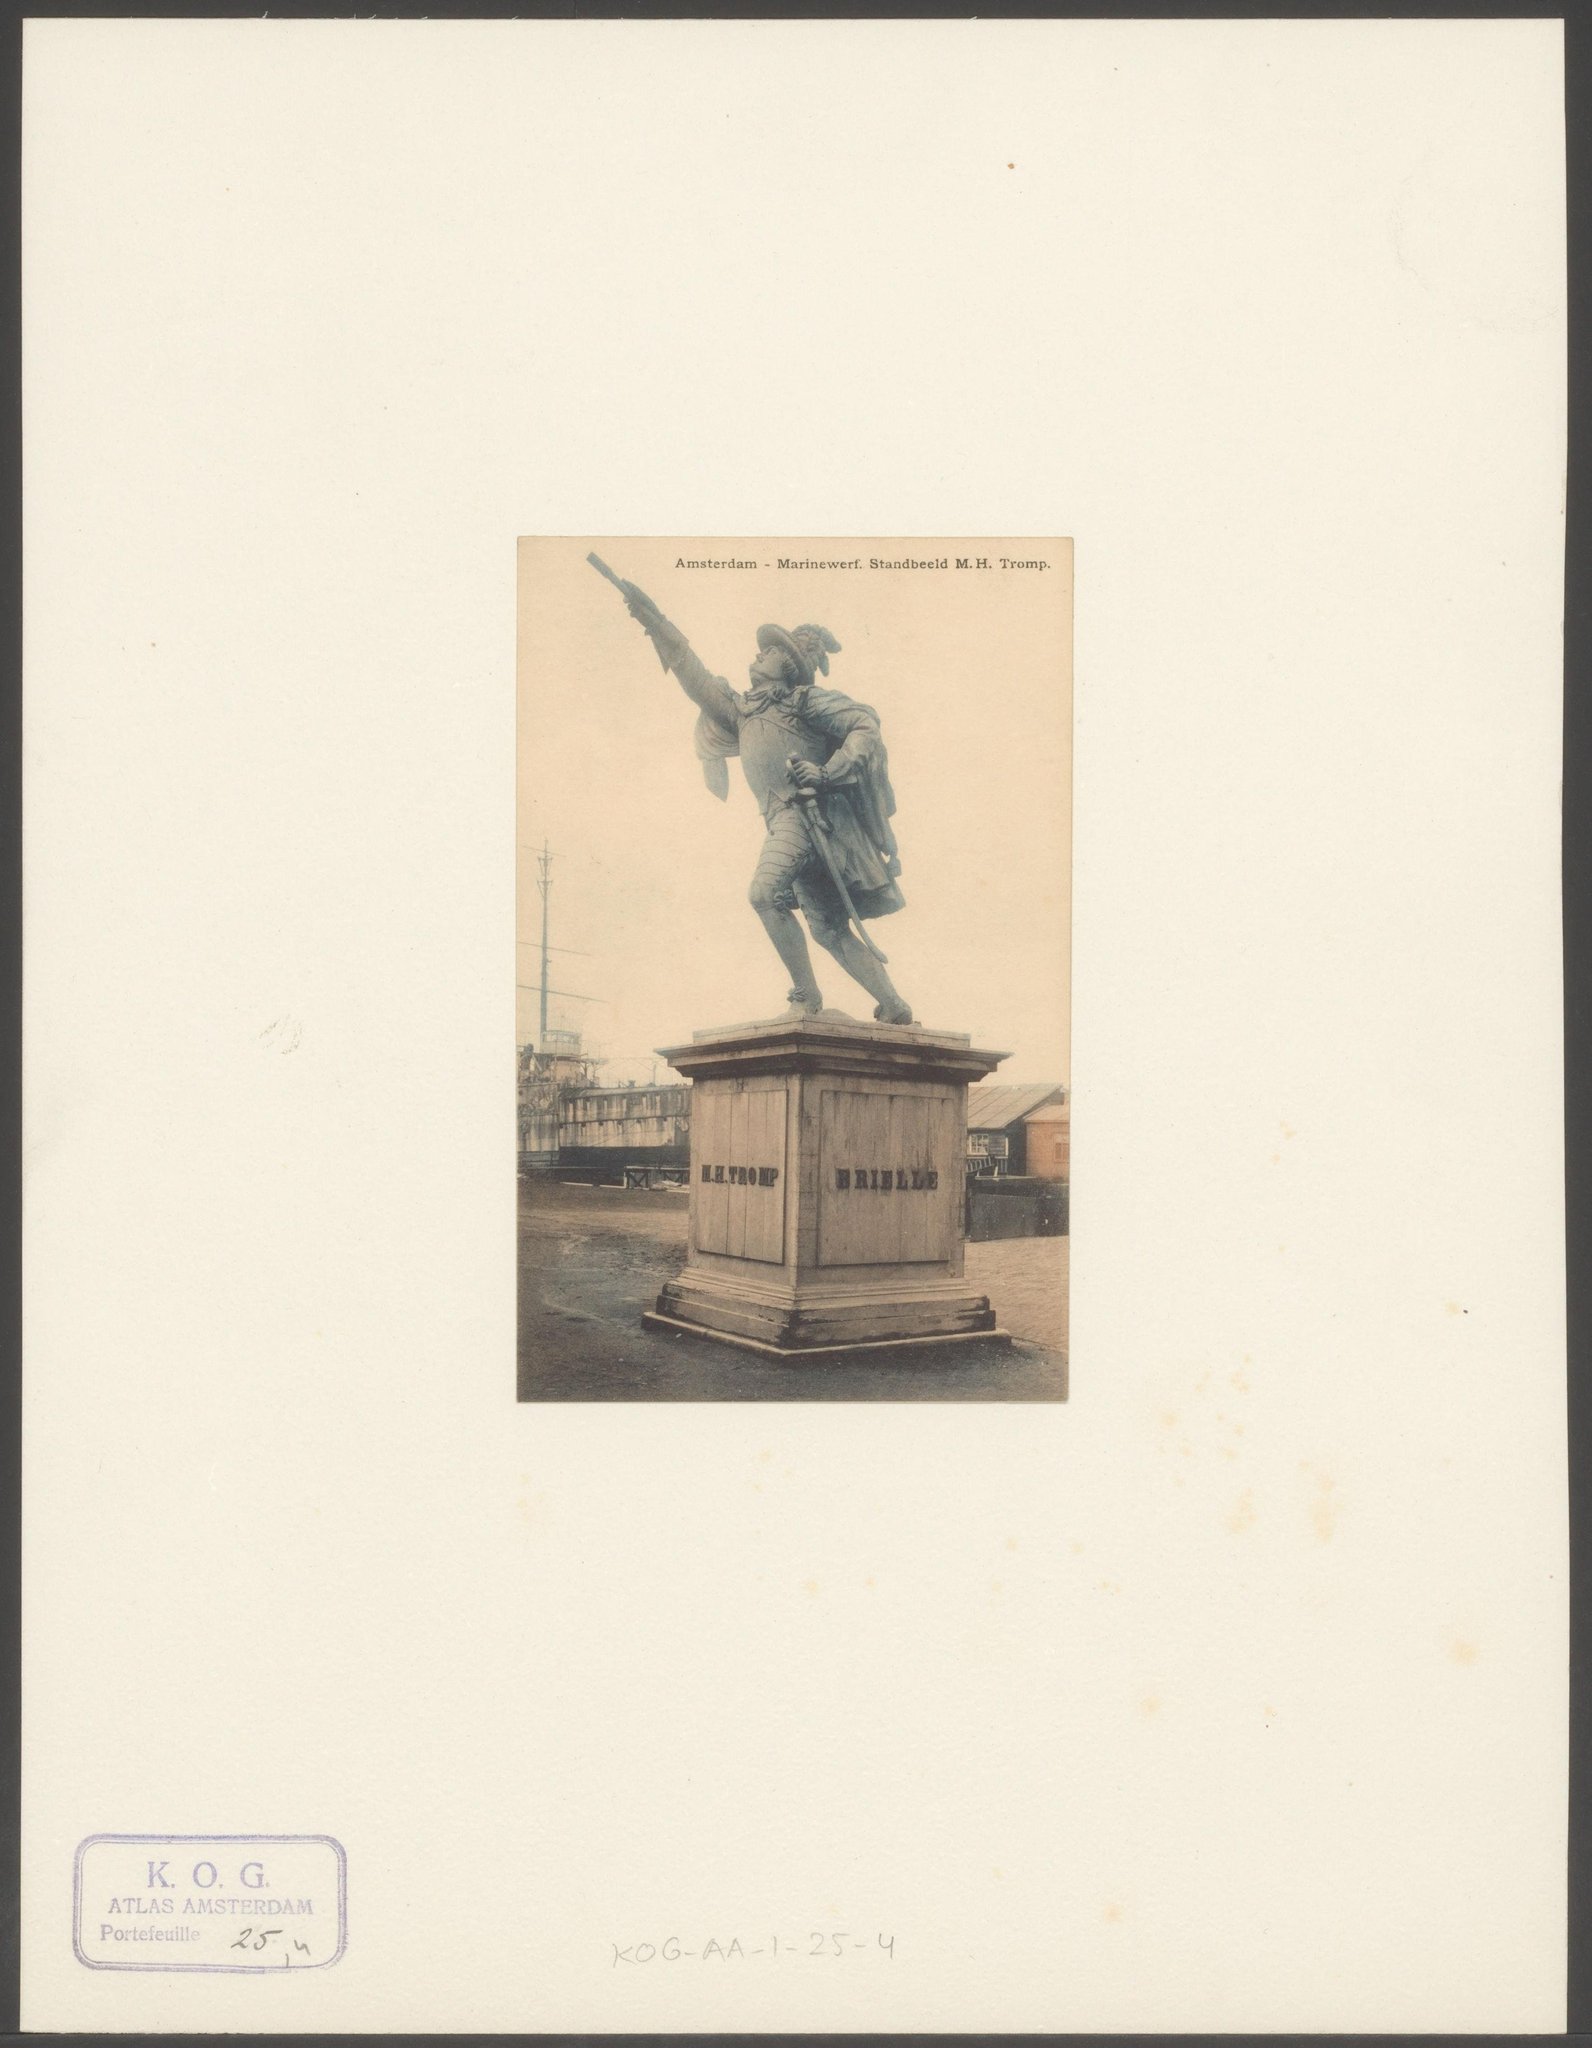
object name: photomechanical print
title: Amsterdam - Marinewerf. Standbeeld M.H. Tromp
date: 1913-1928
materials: cardboard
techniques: collotype process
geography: amsterdam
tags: maarten harpertszoon tromp, monument, statue, shipyard, shipdock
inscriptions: collector's mark: ‘25.4’ Lugt 1641b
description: Grote Kattenburgerstraat 7-17C met het standbeeld van M.H. Tromp. Onderwerpsrubriek binnen de Atlas Amsterdam: Krijgswezen I: De Admiraliteit van Amsterdam, A. Admiraliteitsgebouwen.